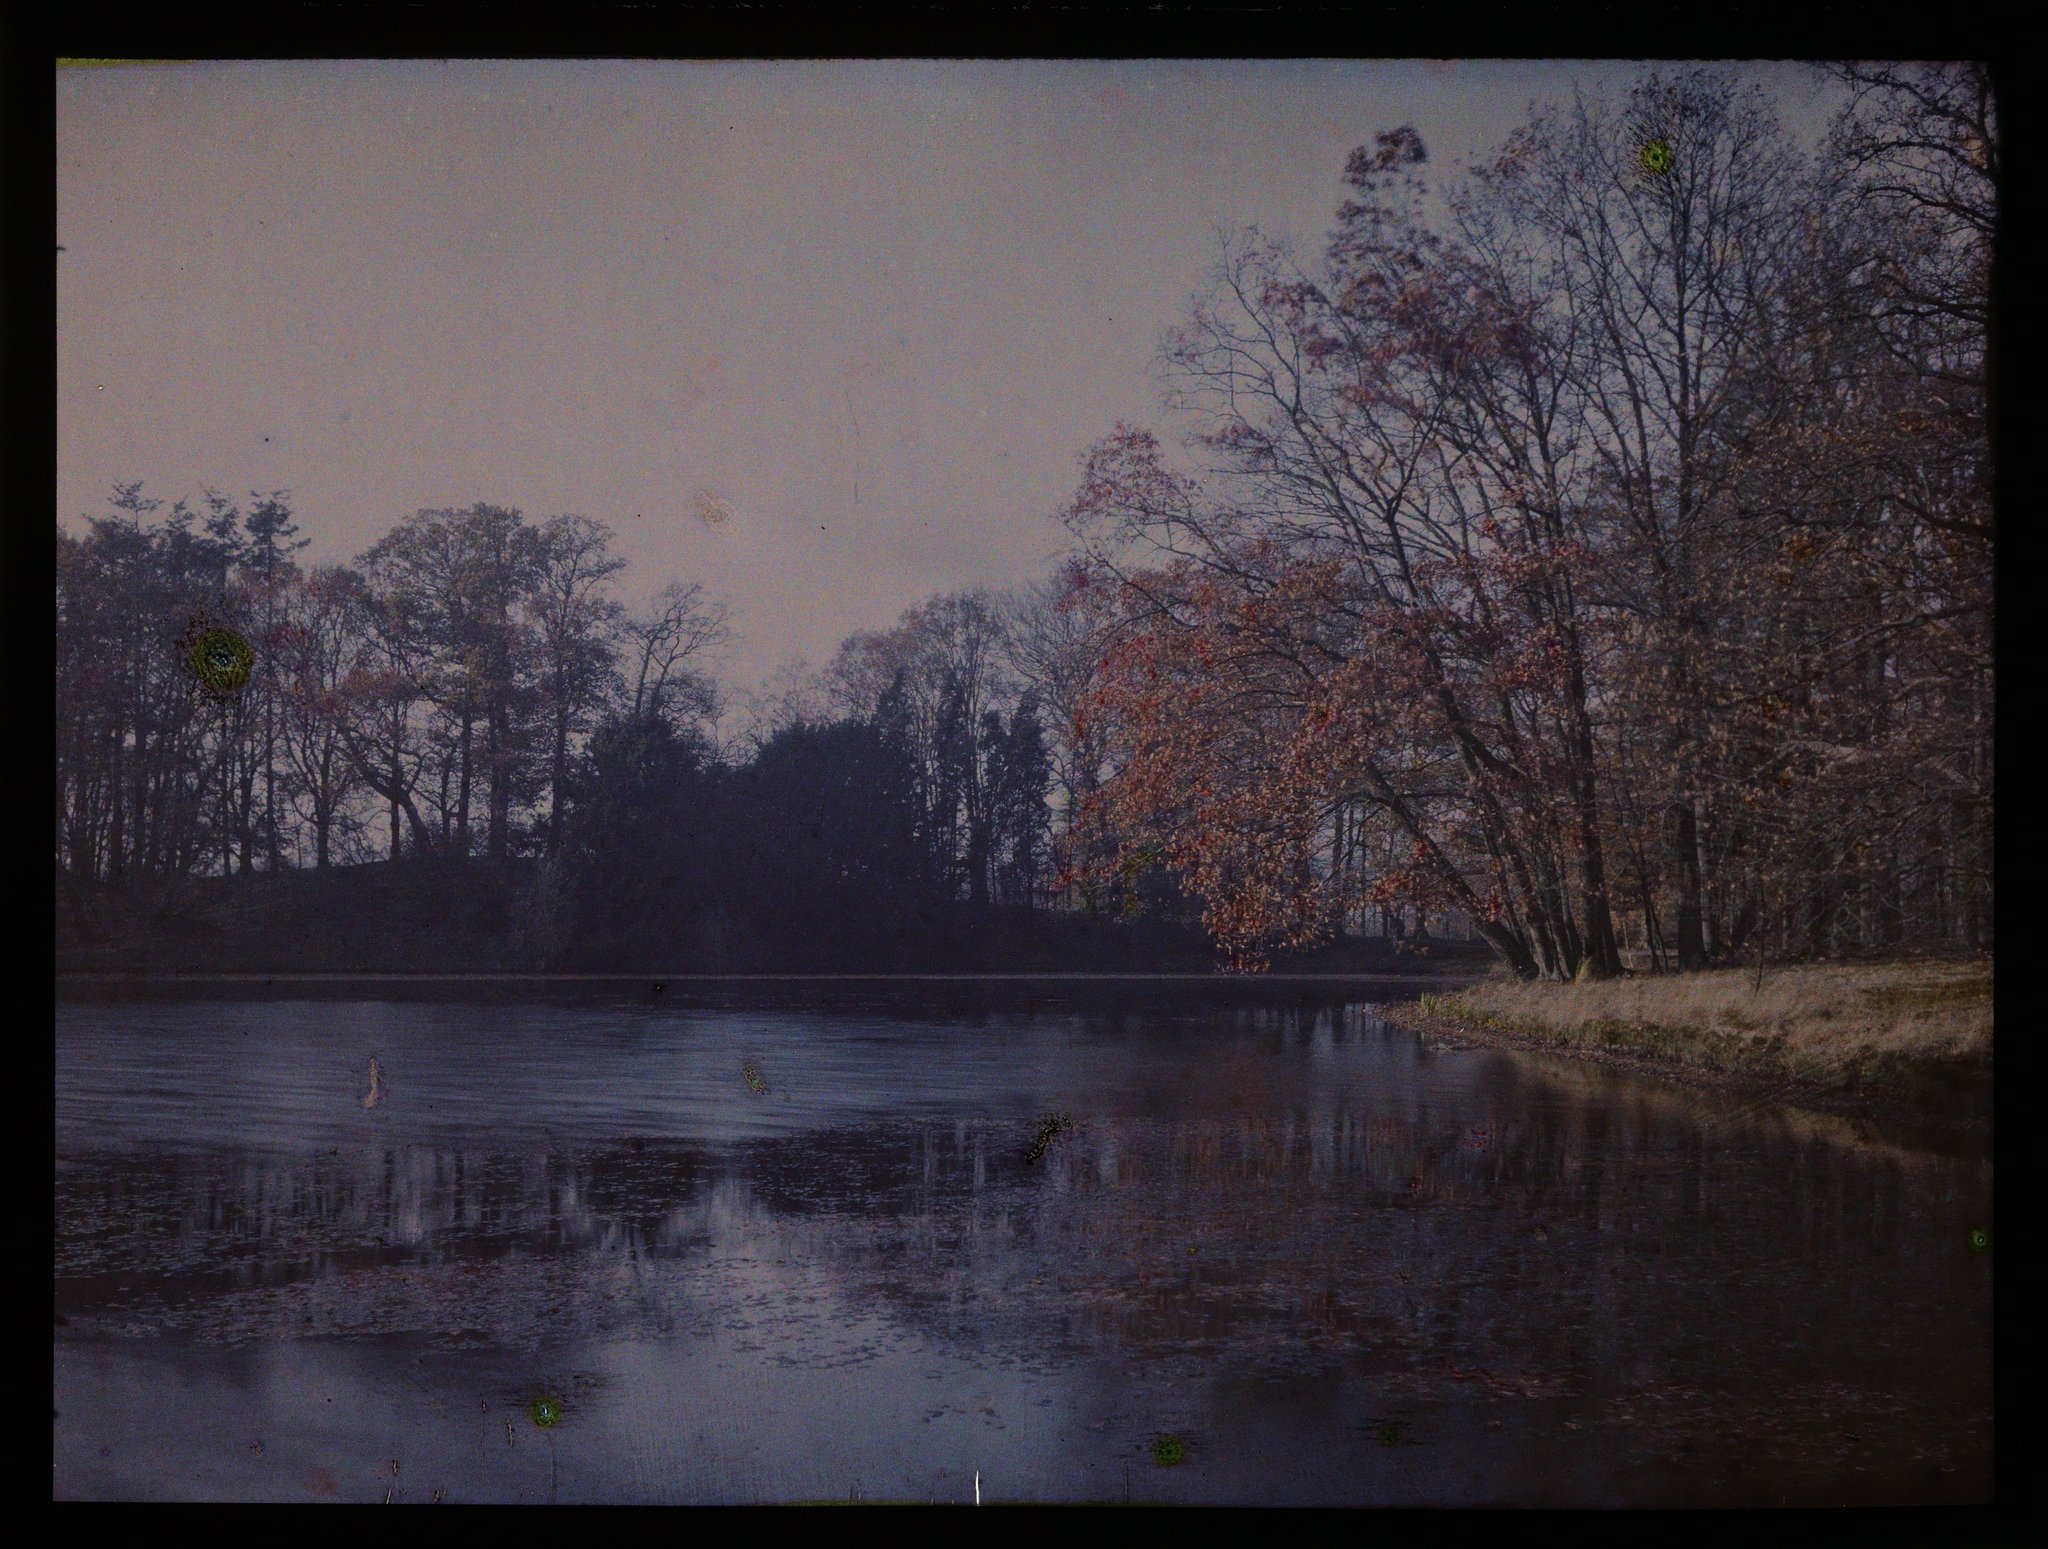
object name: photograph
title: Bevroren vijver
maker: Anonymous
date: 1907-1935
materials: glass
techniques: autochrome process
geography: netherlands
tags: ice ~ freezing weather, netherlands